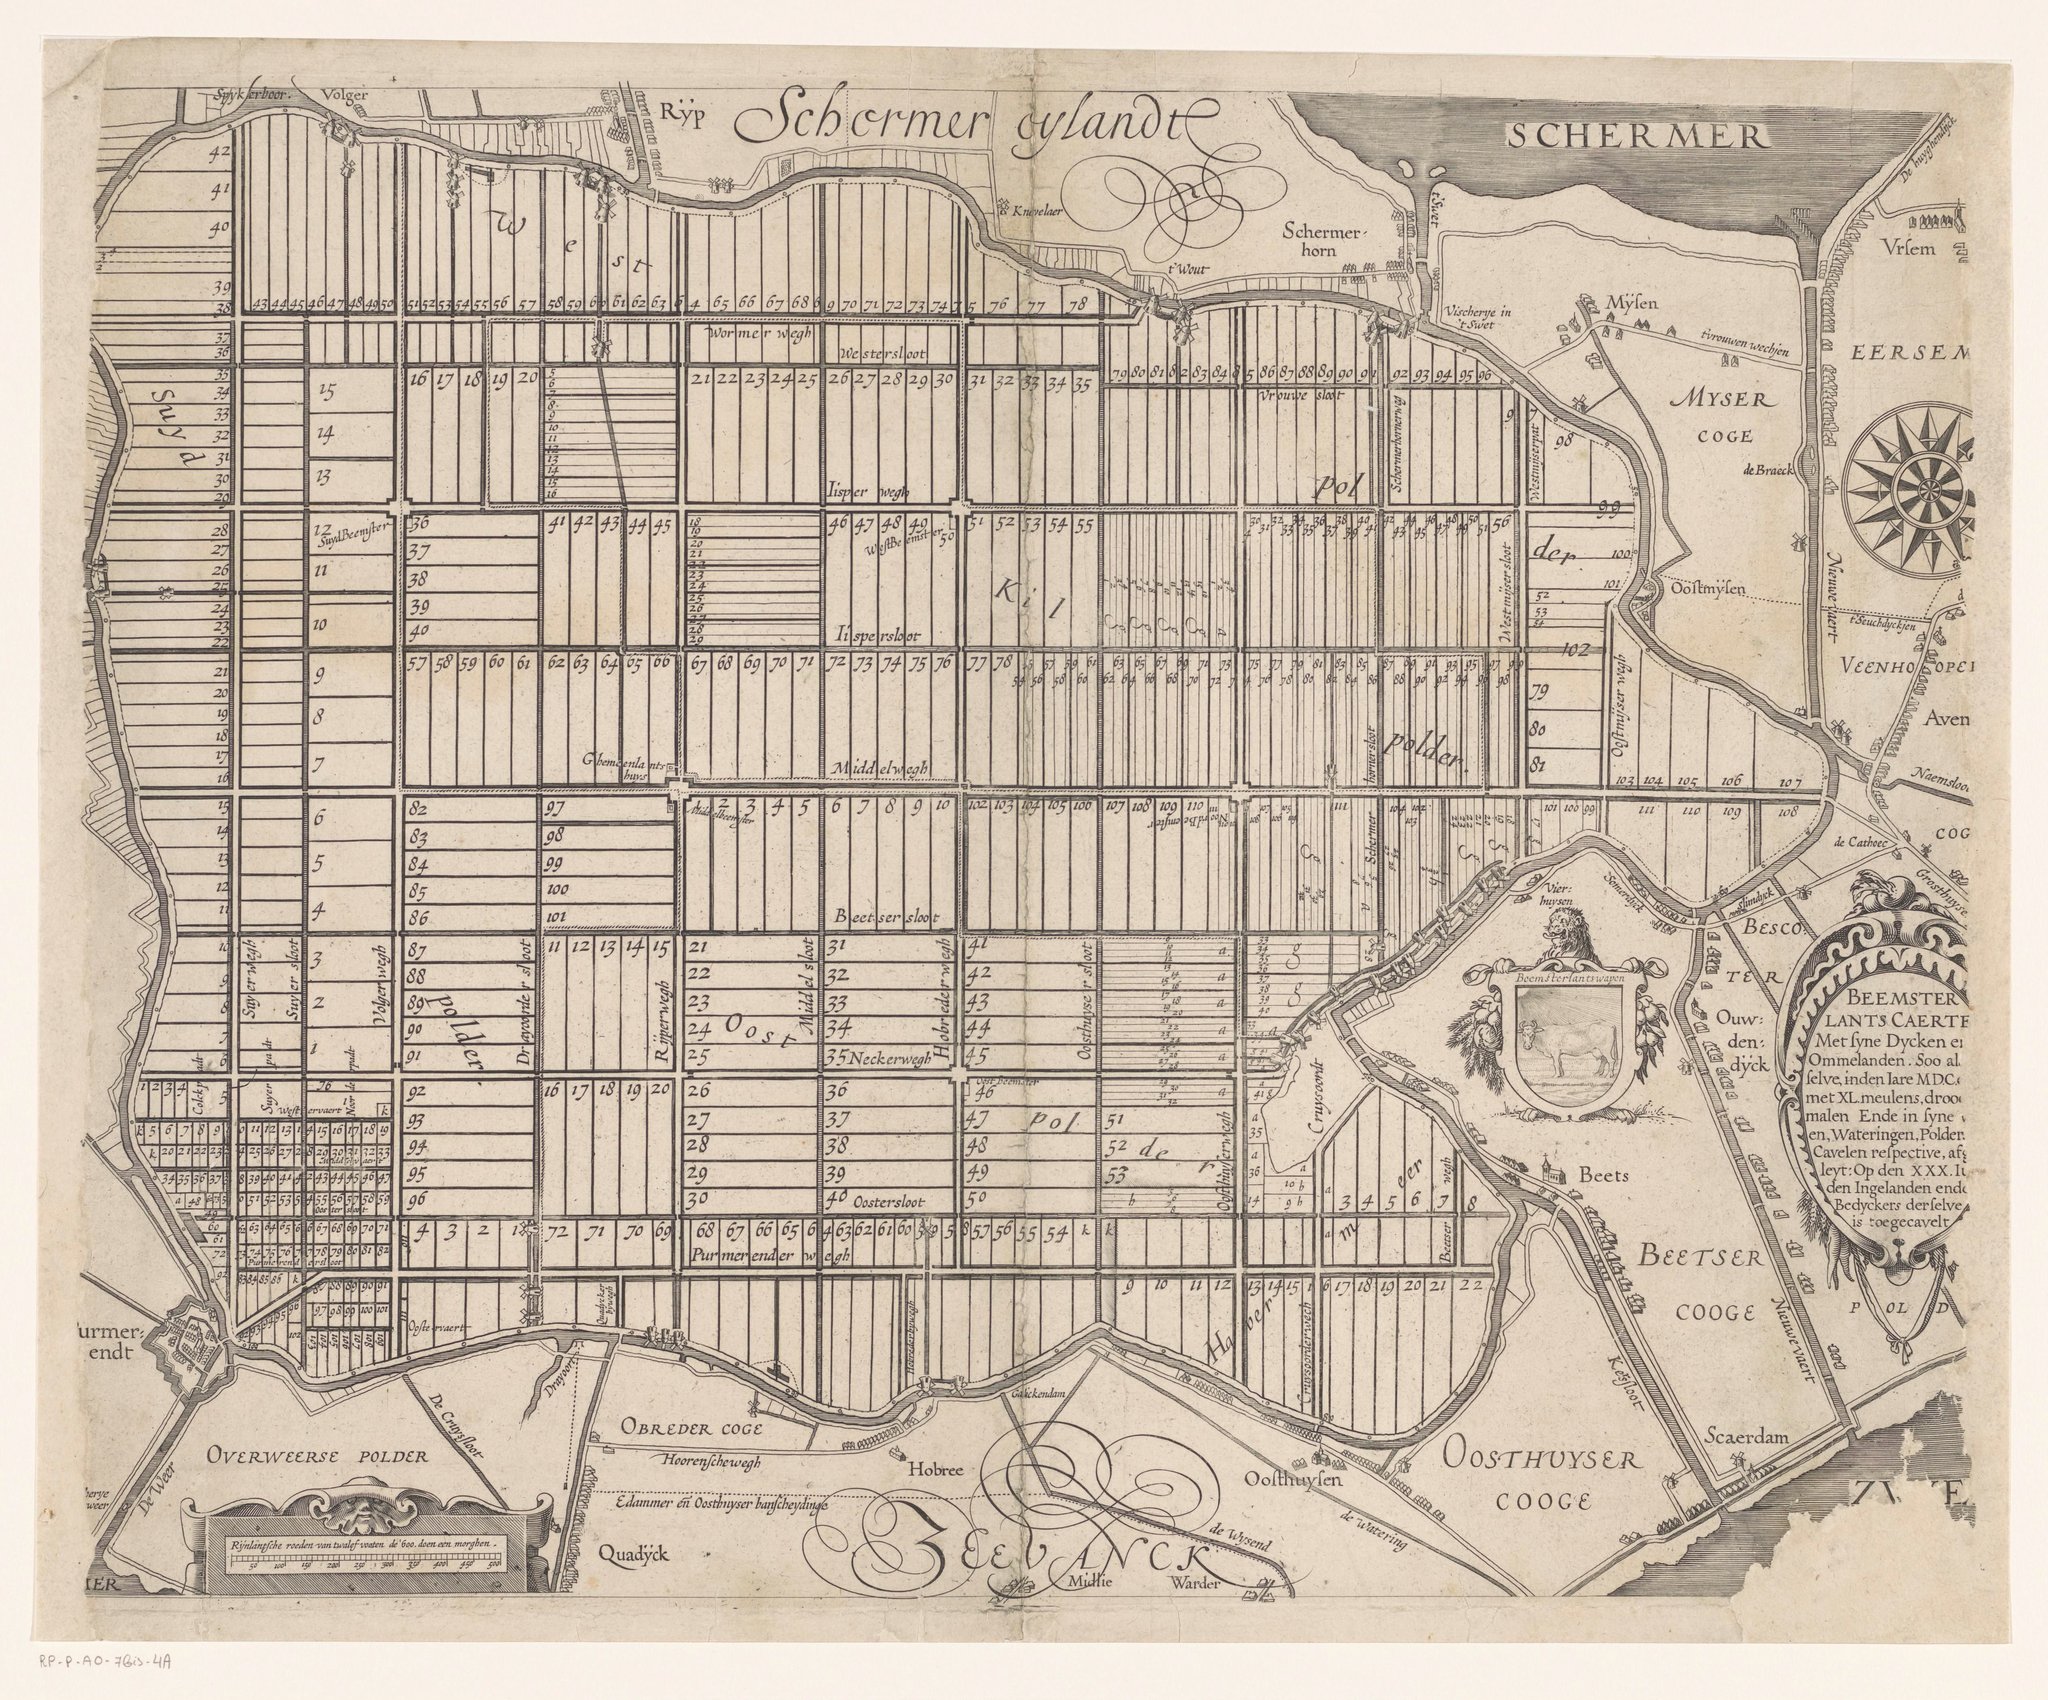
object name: print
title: Kaart van de Beemster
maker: Anonymous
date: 1612-1650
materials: paper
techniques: engraving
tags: maps of separate countries or regions, beemster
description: Kaart van de Beemster na de drooglegging (voltooid in 1612). Linksonder een schaalstok: Rijnlantsche roeden van twalef voeten de 600 doen een morghen. Rechts het wapen van de Beemster met daarboven een leeuw, rechts daarvan de titelcartouche. Oriëntatie: noorden rechts.